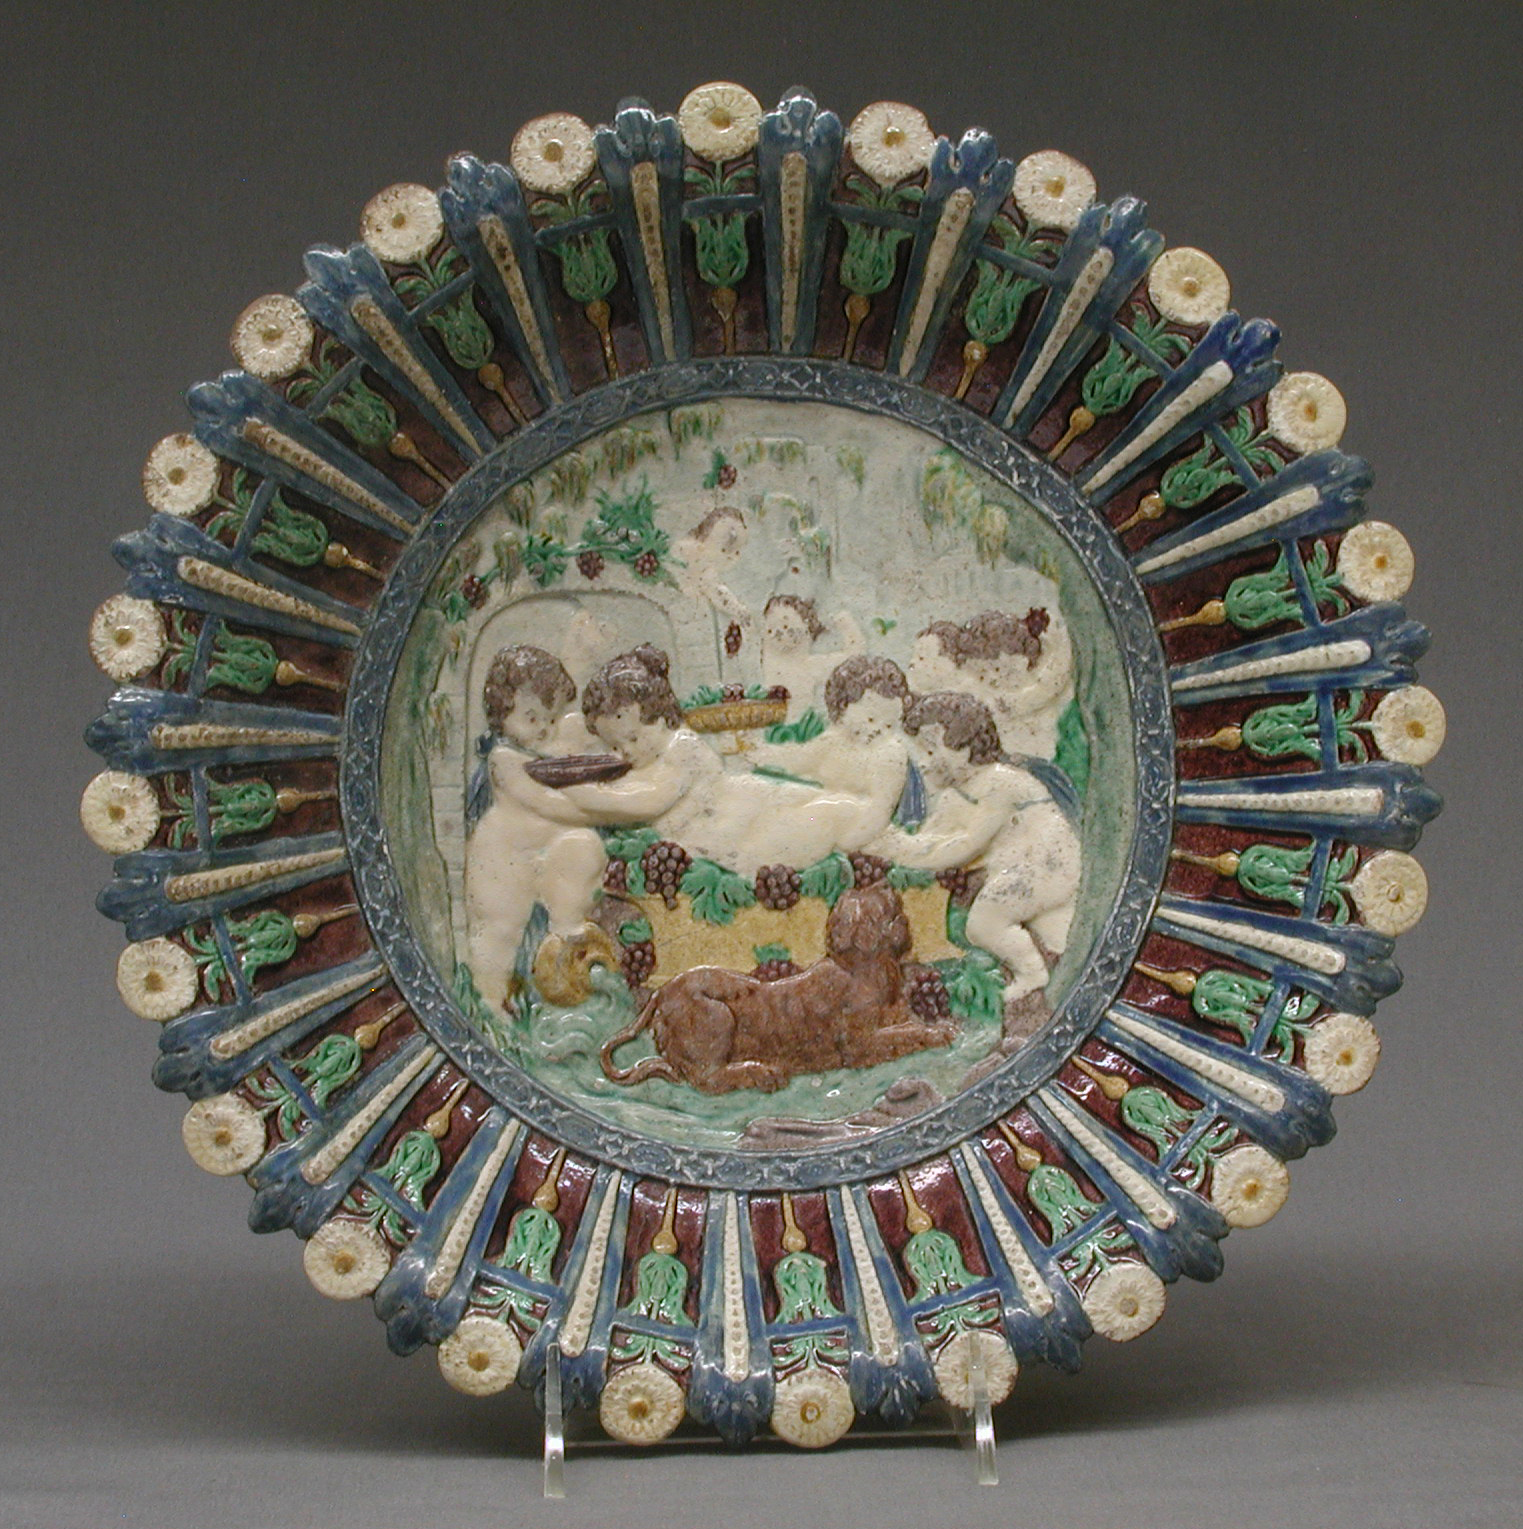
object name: dish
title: Dish with childhood of Bacchus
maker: bernard palissy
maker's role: maker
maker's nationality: french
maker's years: 1510-1590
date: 1801-1900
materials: earthenware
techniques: glazing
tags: animals,grapes,bacchus